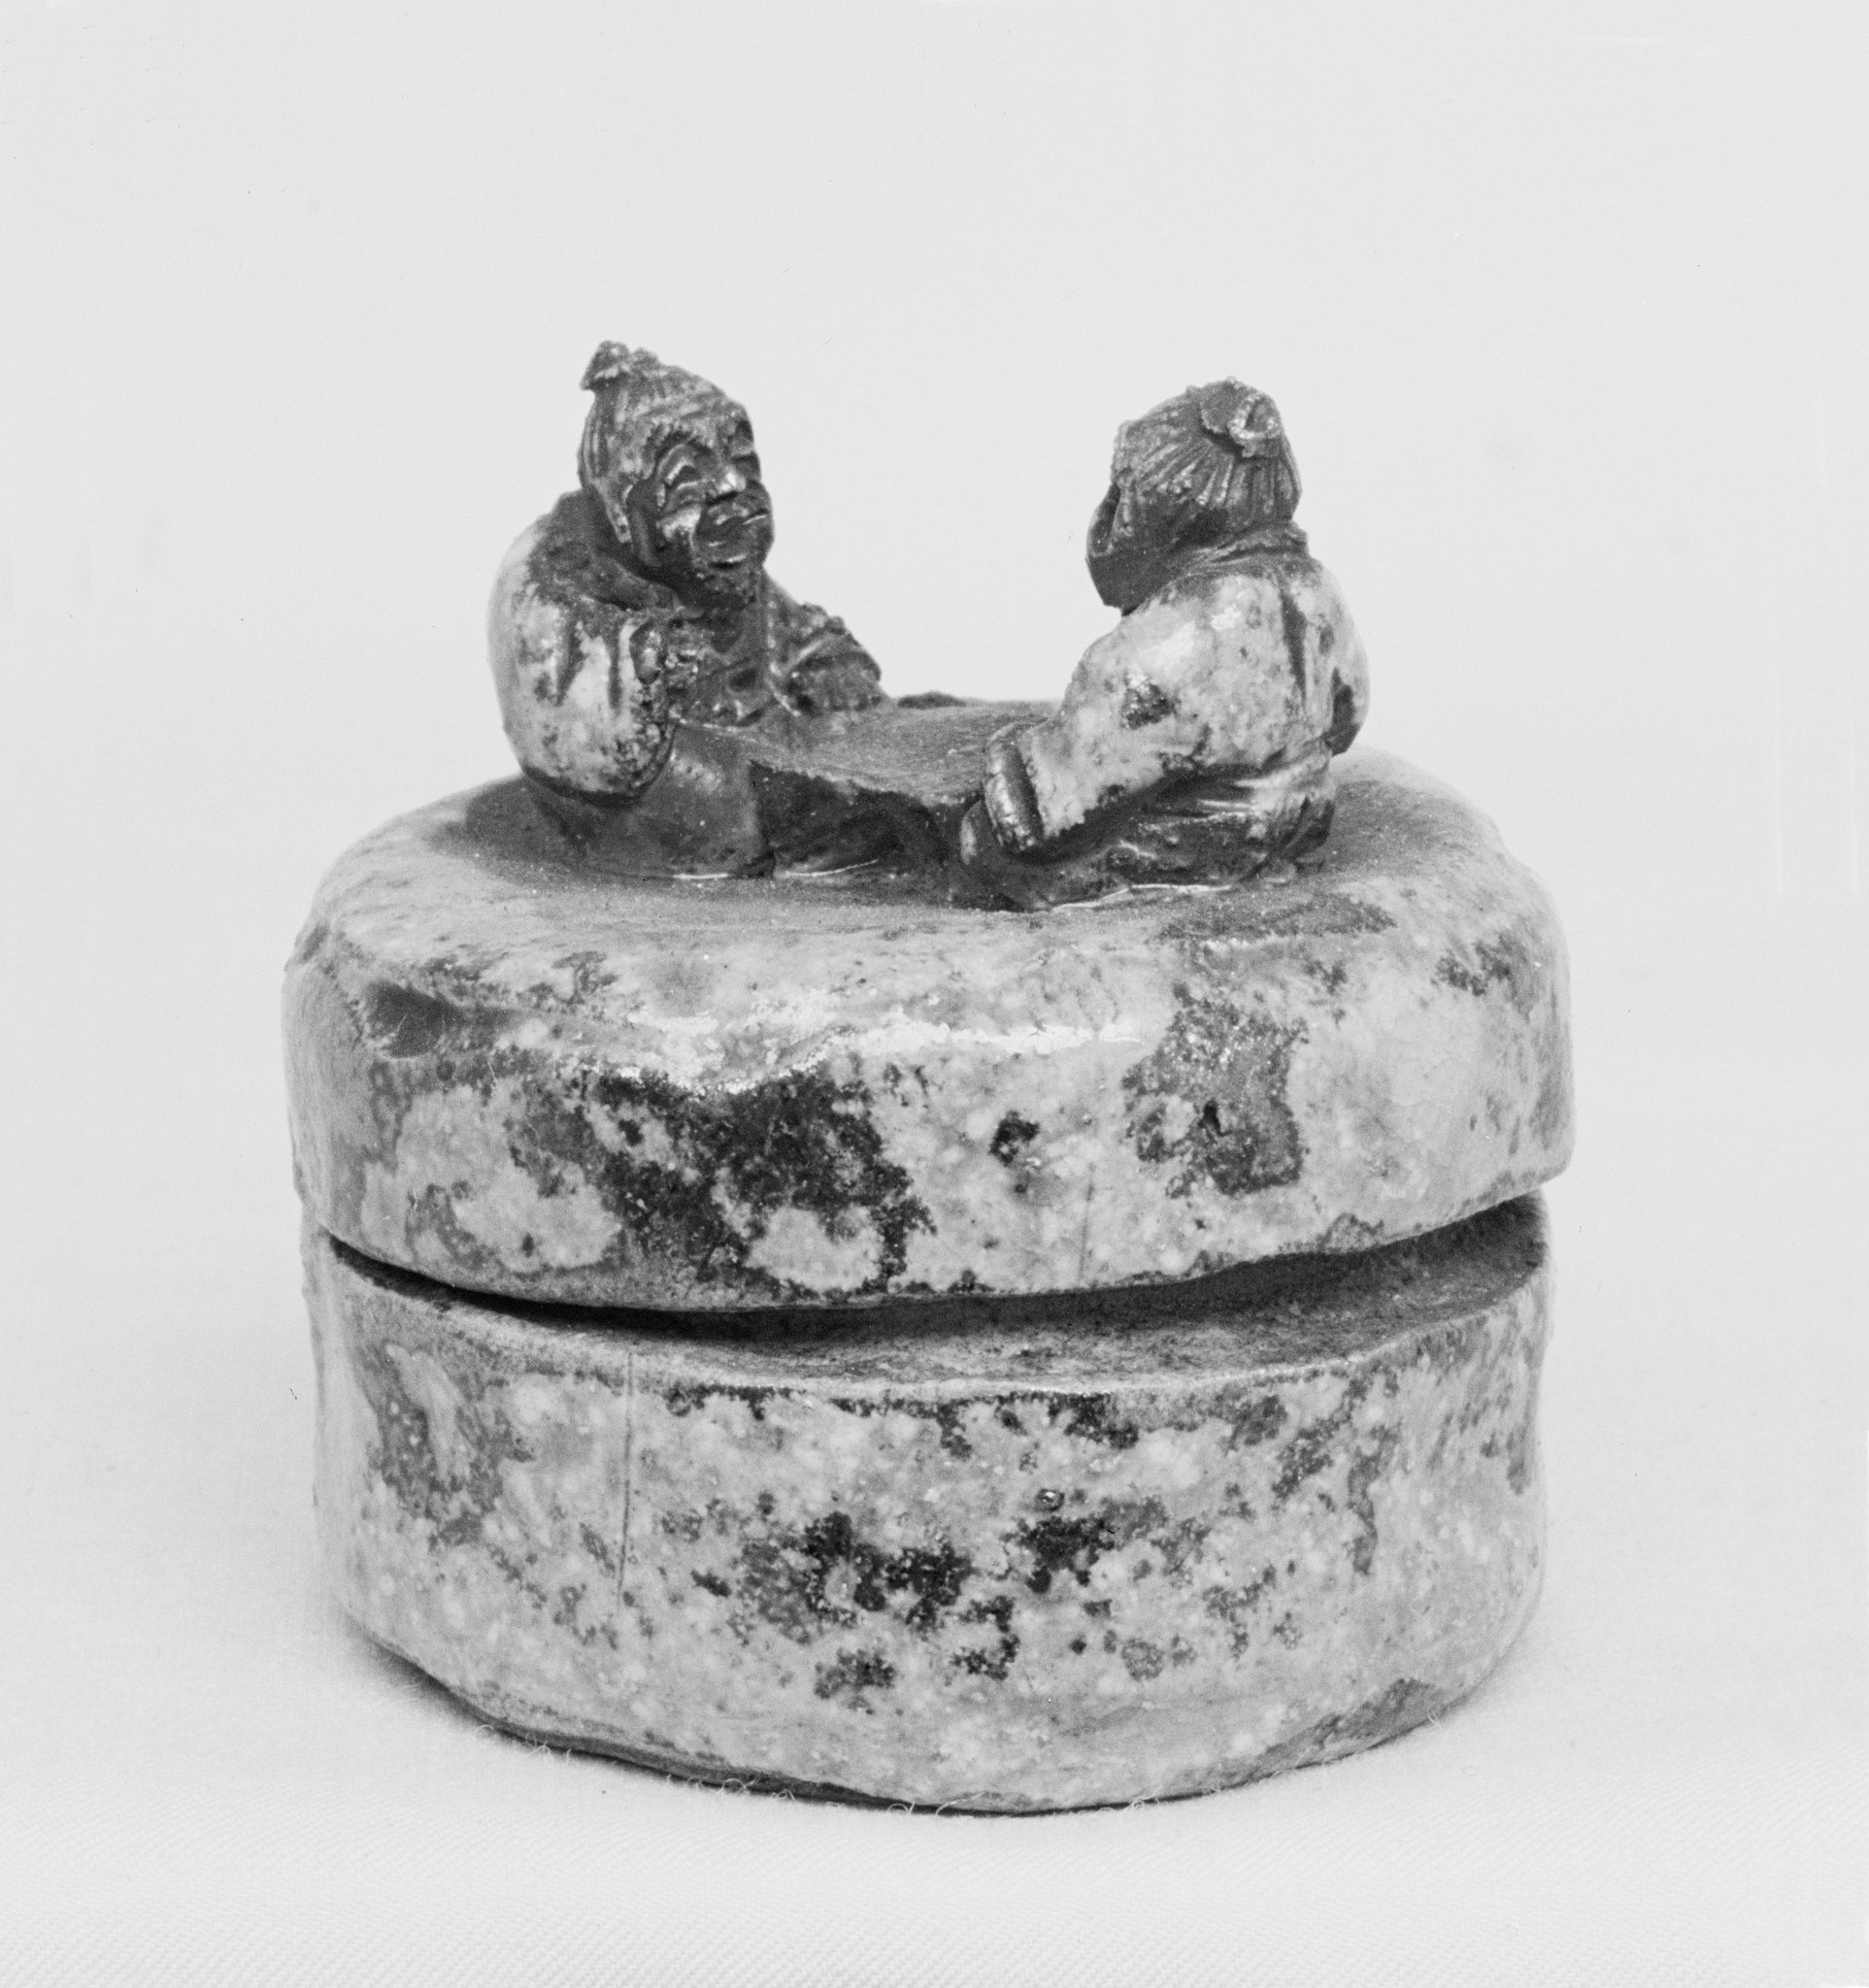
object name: incense box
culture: japanese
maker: dr. bunkio masaki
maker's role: artist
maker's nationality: japanese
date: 1801-1900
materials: clay, glaze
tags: human figures